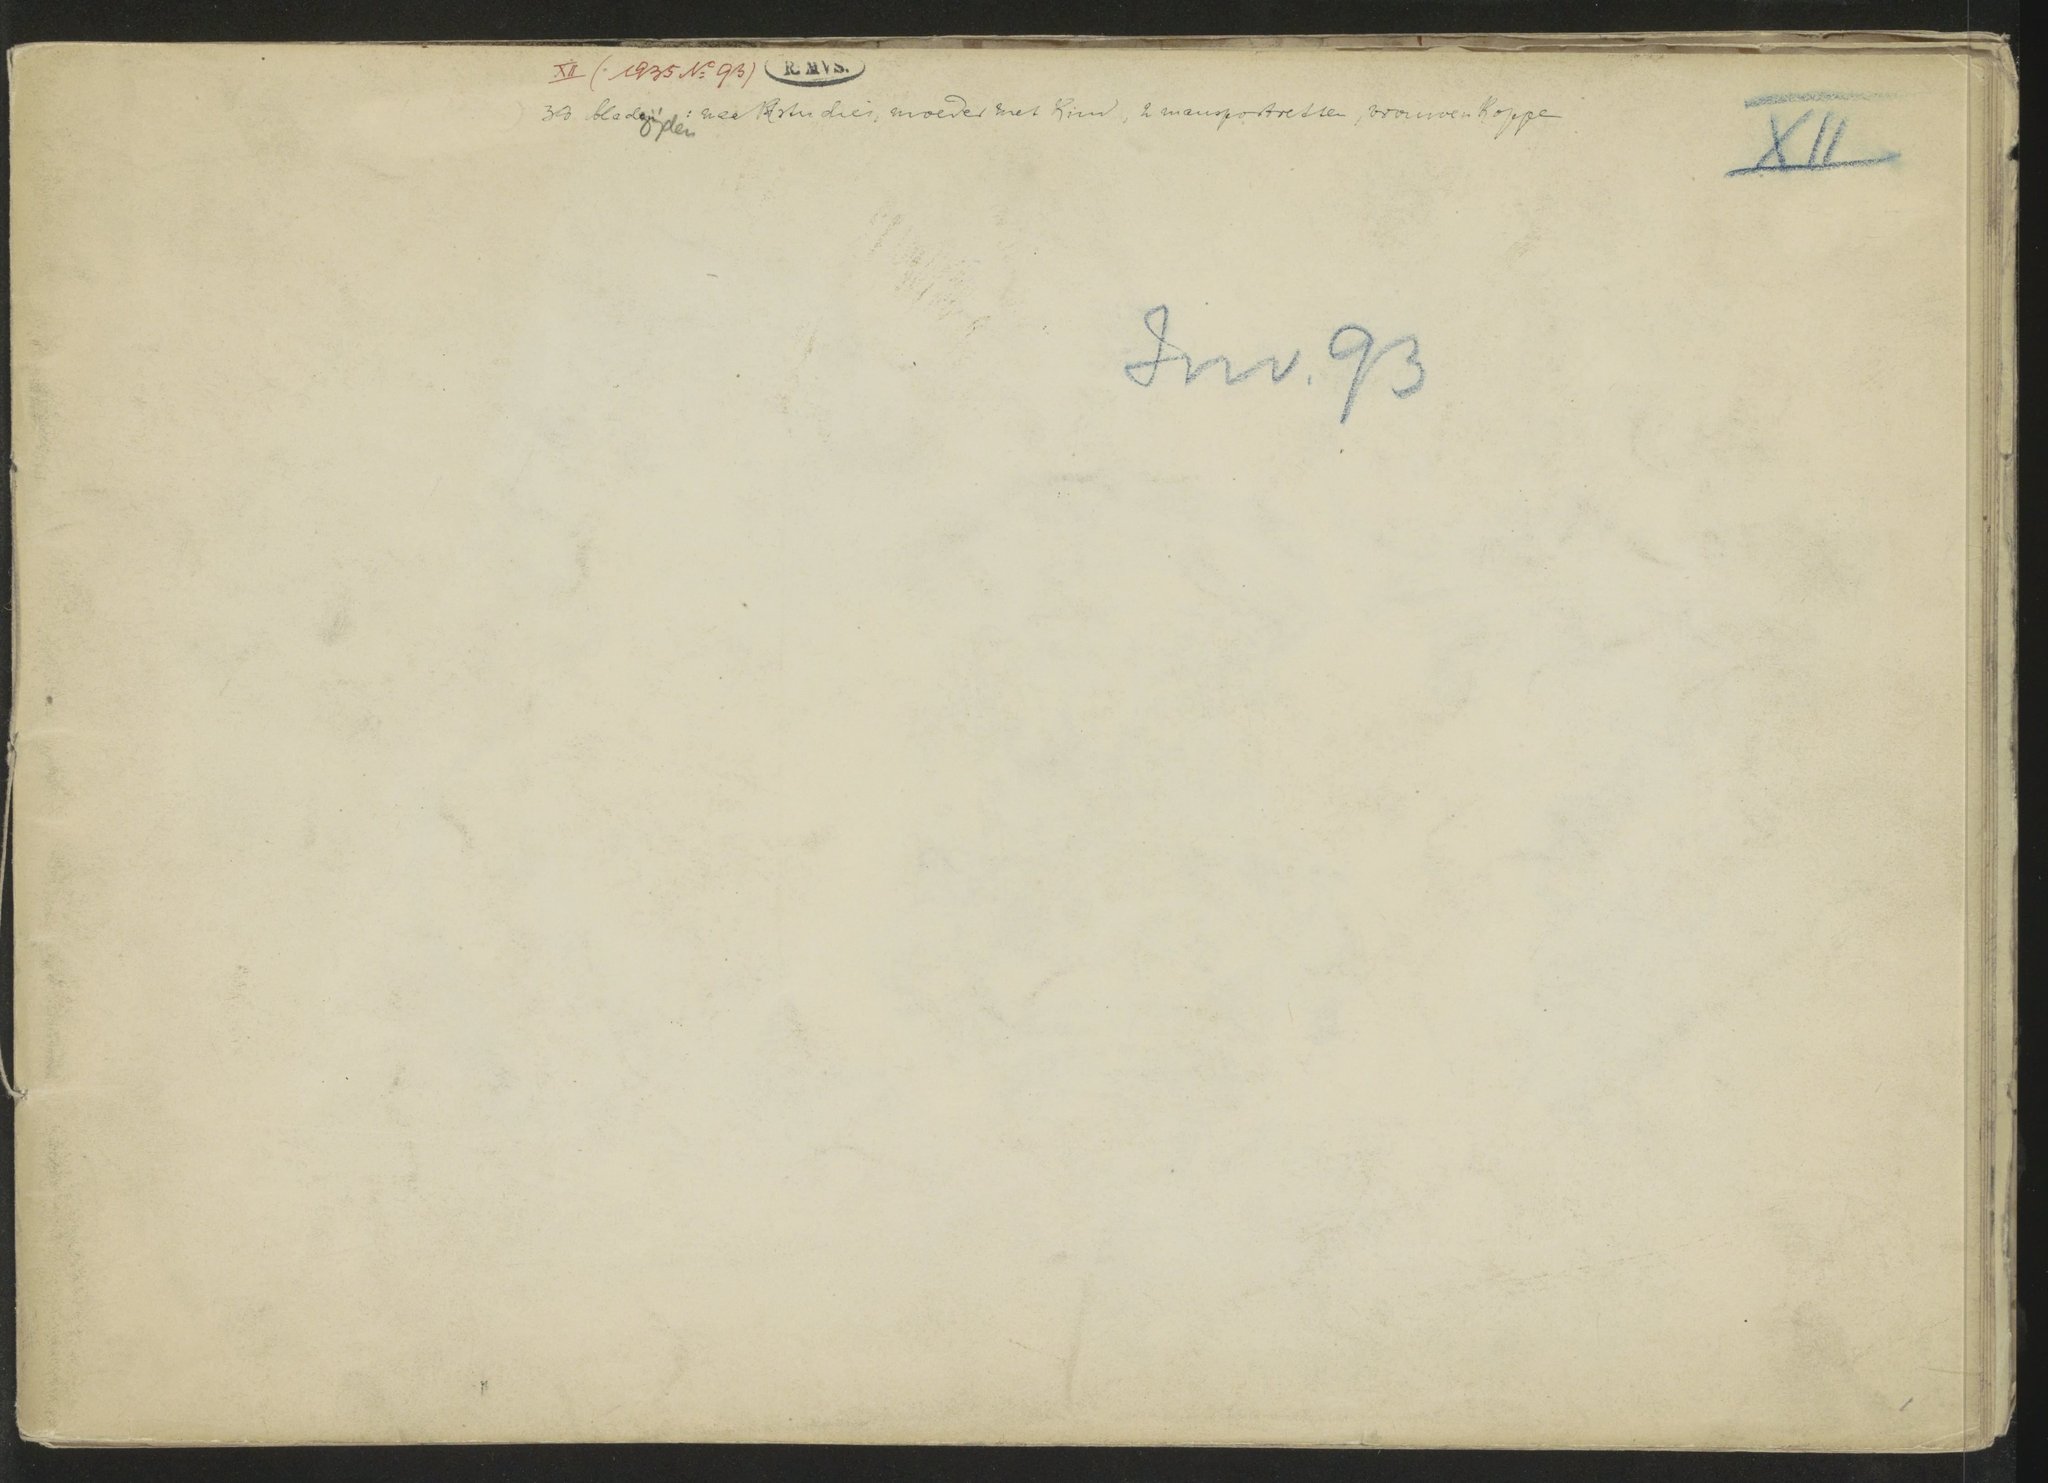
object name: sketchbook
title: Schetsboek XII met 19 bladen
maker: isaac israels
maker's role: draughtsman, painter, print maker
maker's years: 1865-1934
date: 1875-1934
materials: chalk, ink, paper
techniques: pen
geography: the hague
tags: the (nude) human figure; 'corpo humano' (ripa) - aa - female human figure (+ lying), head (human) - aa - female human figure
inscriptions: collector's mark: Lugt 2228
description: Bladen 1(R), 12(V), 13(R), 14(R), 16(V) t/m 18(R) en 19(R) zijn blanco en daarom niet beschreven.